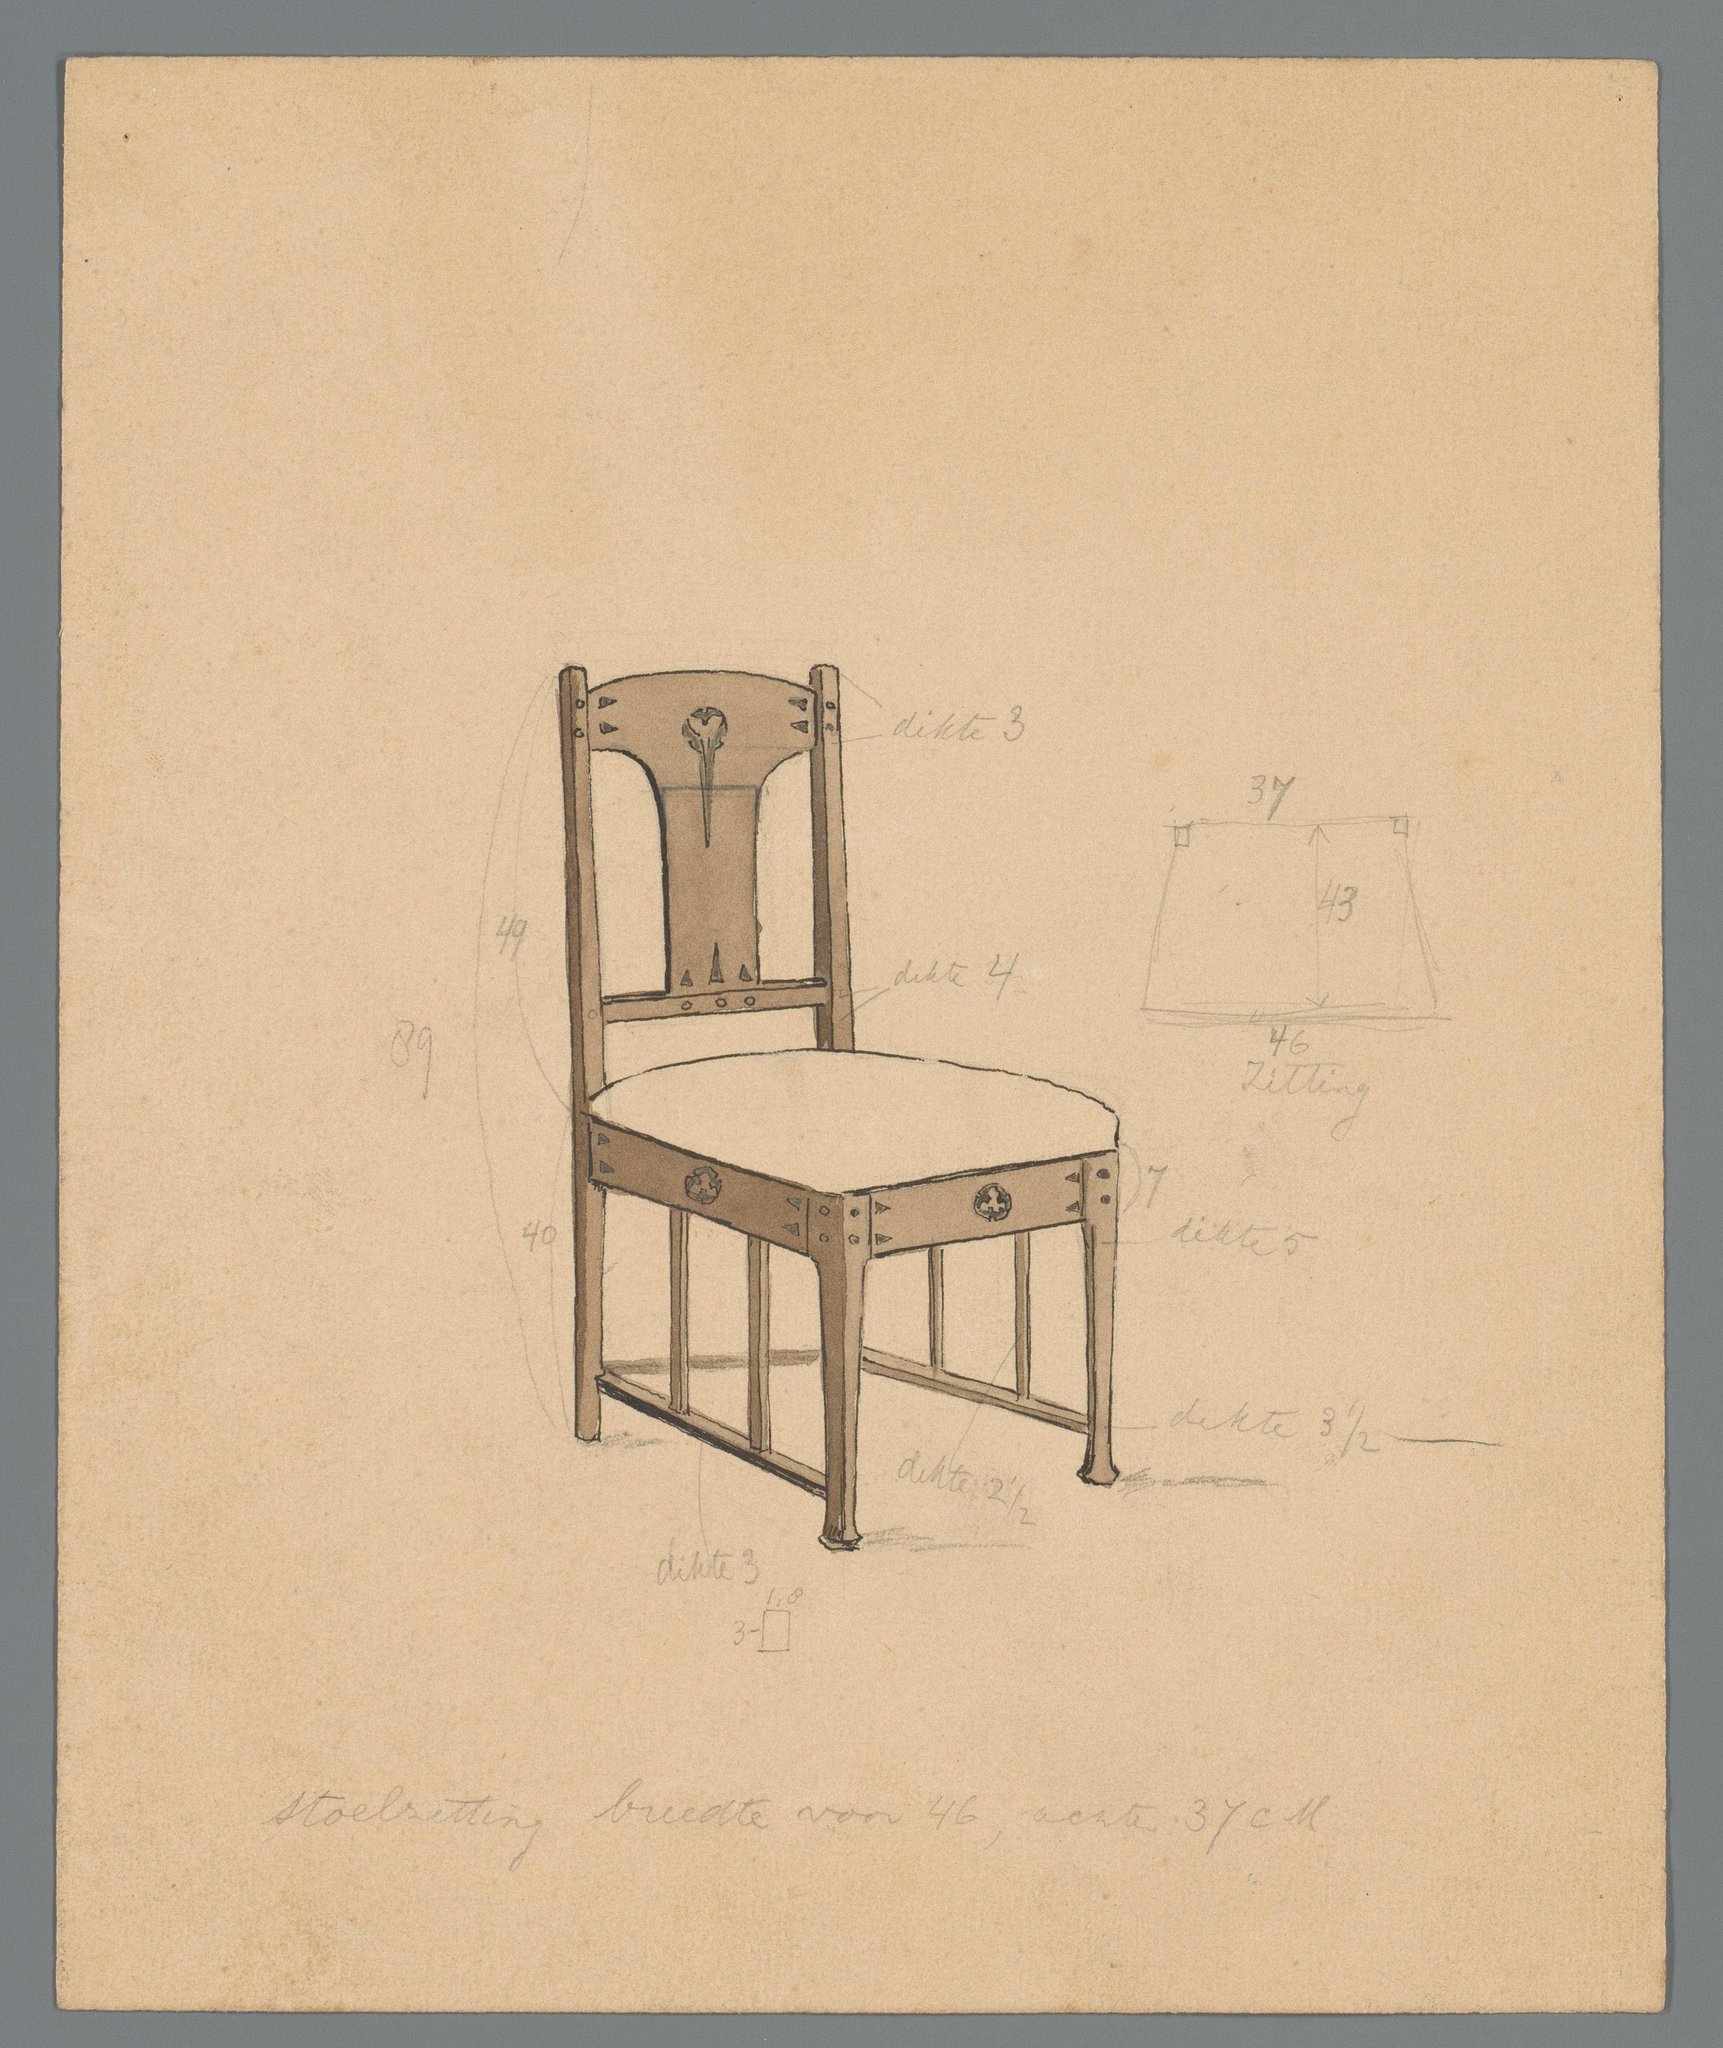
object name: design drawing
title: Ontwerp voor een stoel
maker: gust van de wall perné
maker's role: draughtsman, painter, print maker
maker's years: 1877-1911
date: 1887-1911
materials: ink, paper, pencil, watercolor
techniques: brush, pen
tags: chair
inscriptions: collector's mark: Lugt 2228